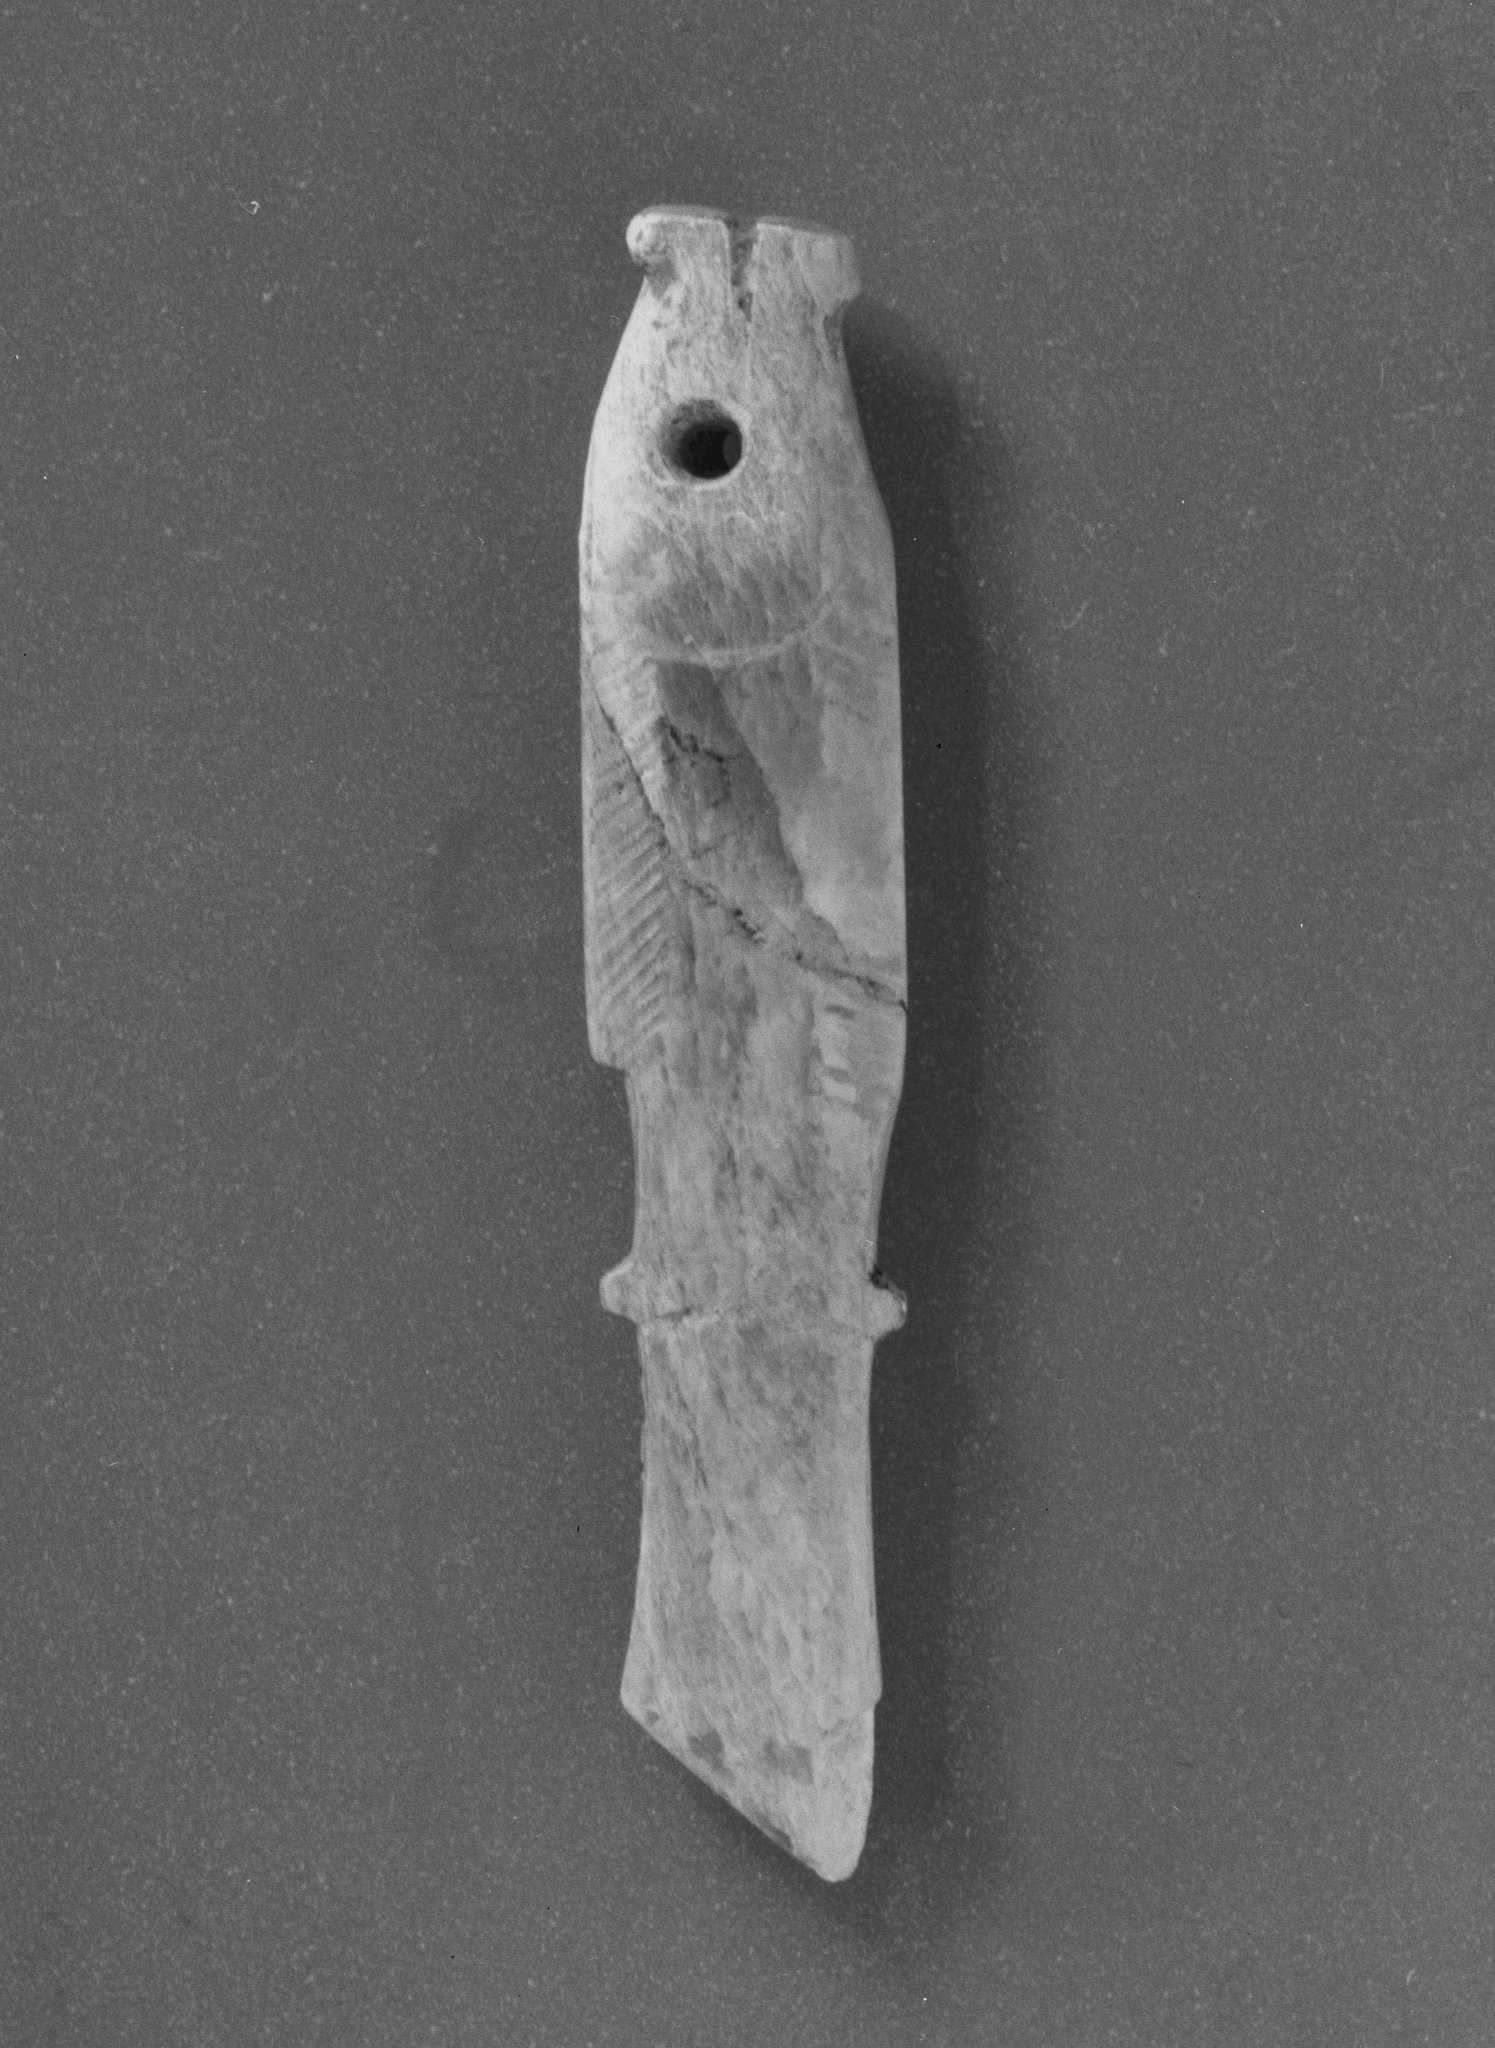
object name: plaque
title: Plaque in the shape of a fish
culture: chinese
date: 1600-771 BCE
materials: jade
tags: fish